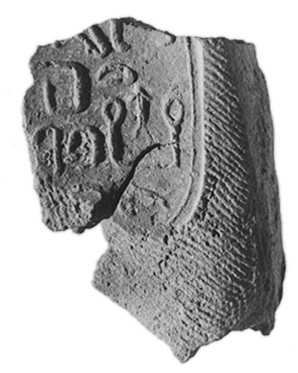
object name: sealing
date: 2030-1640 BCE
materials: clay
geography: egypt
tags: hieroglyphs